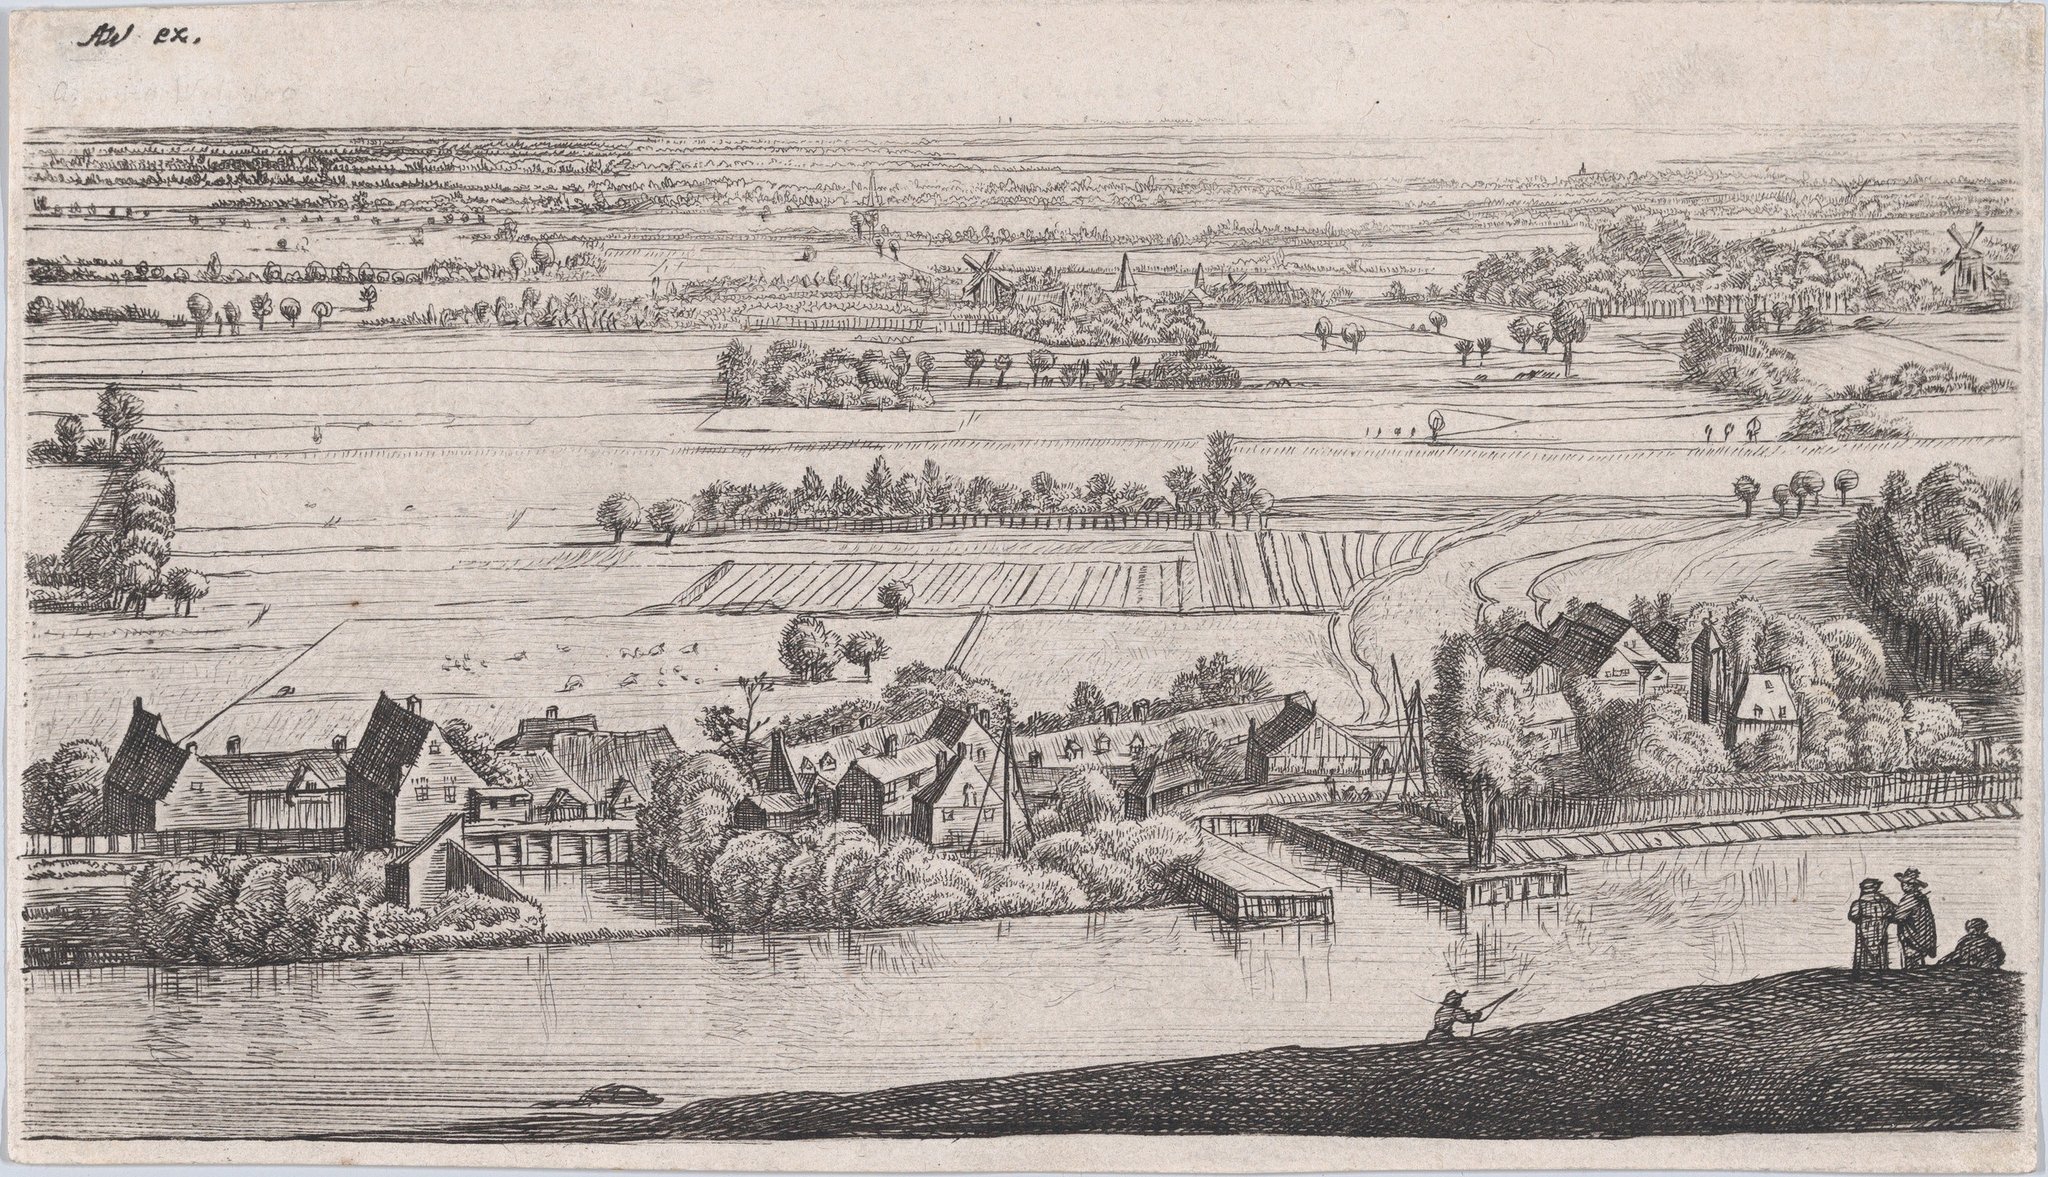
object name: print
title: Village on a River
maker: jan ruischer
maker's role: artist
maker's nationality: dutch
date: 1601-1700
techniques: drypoint, etching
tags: houses,villages,rivers,trees